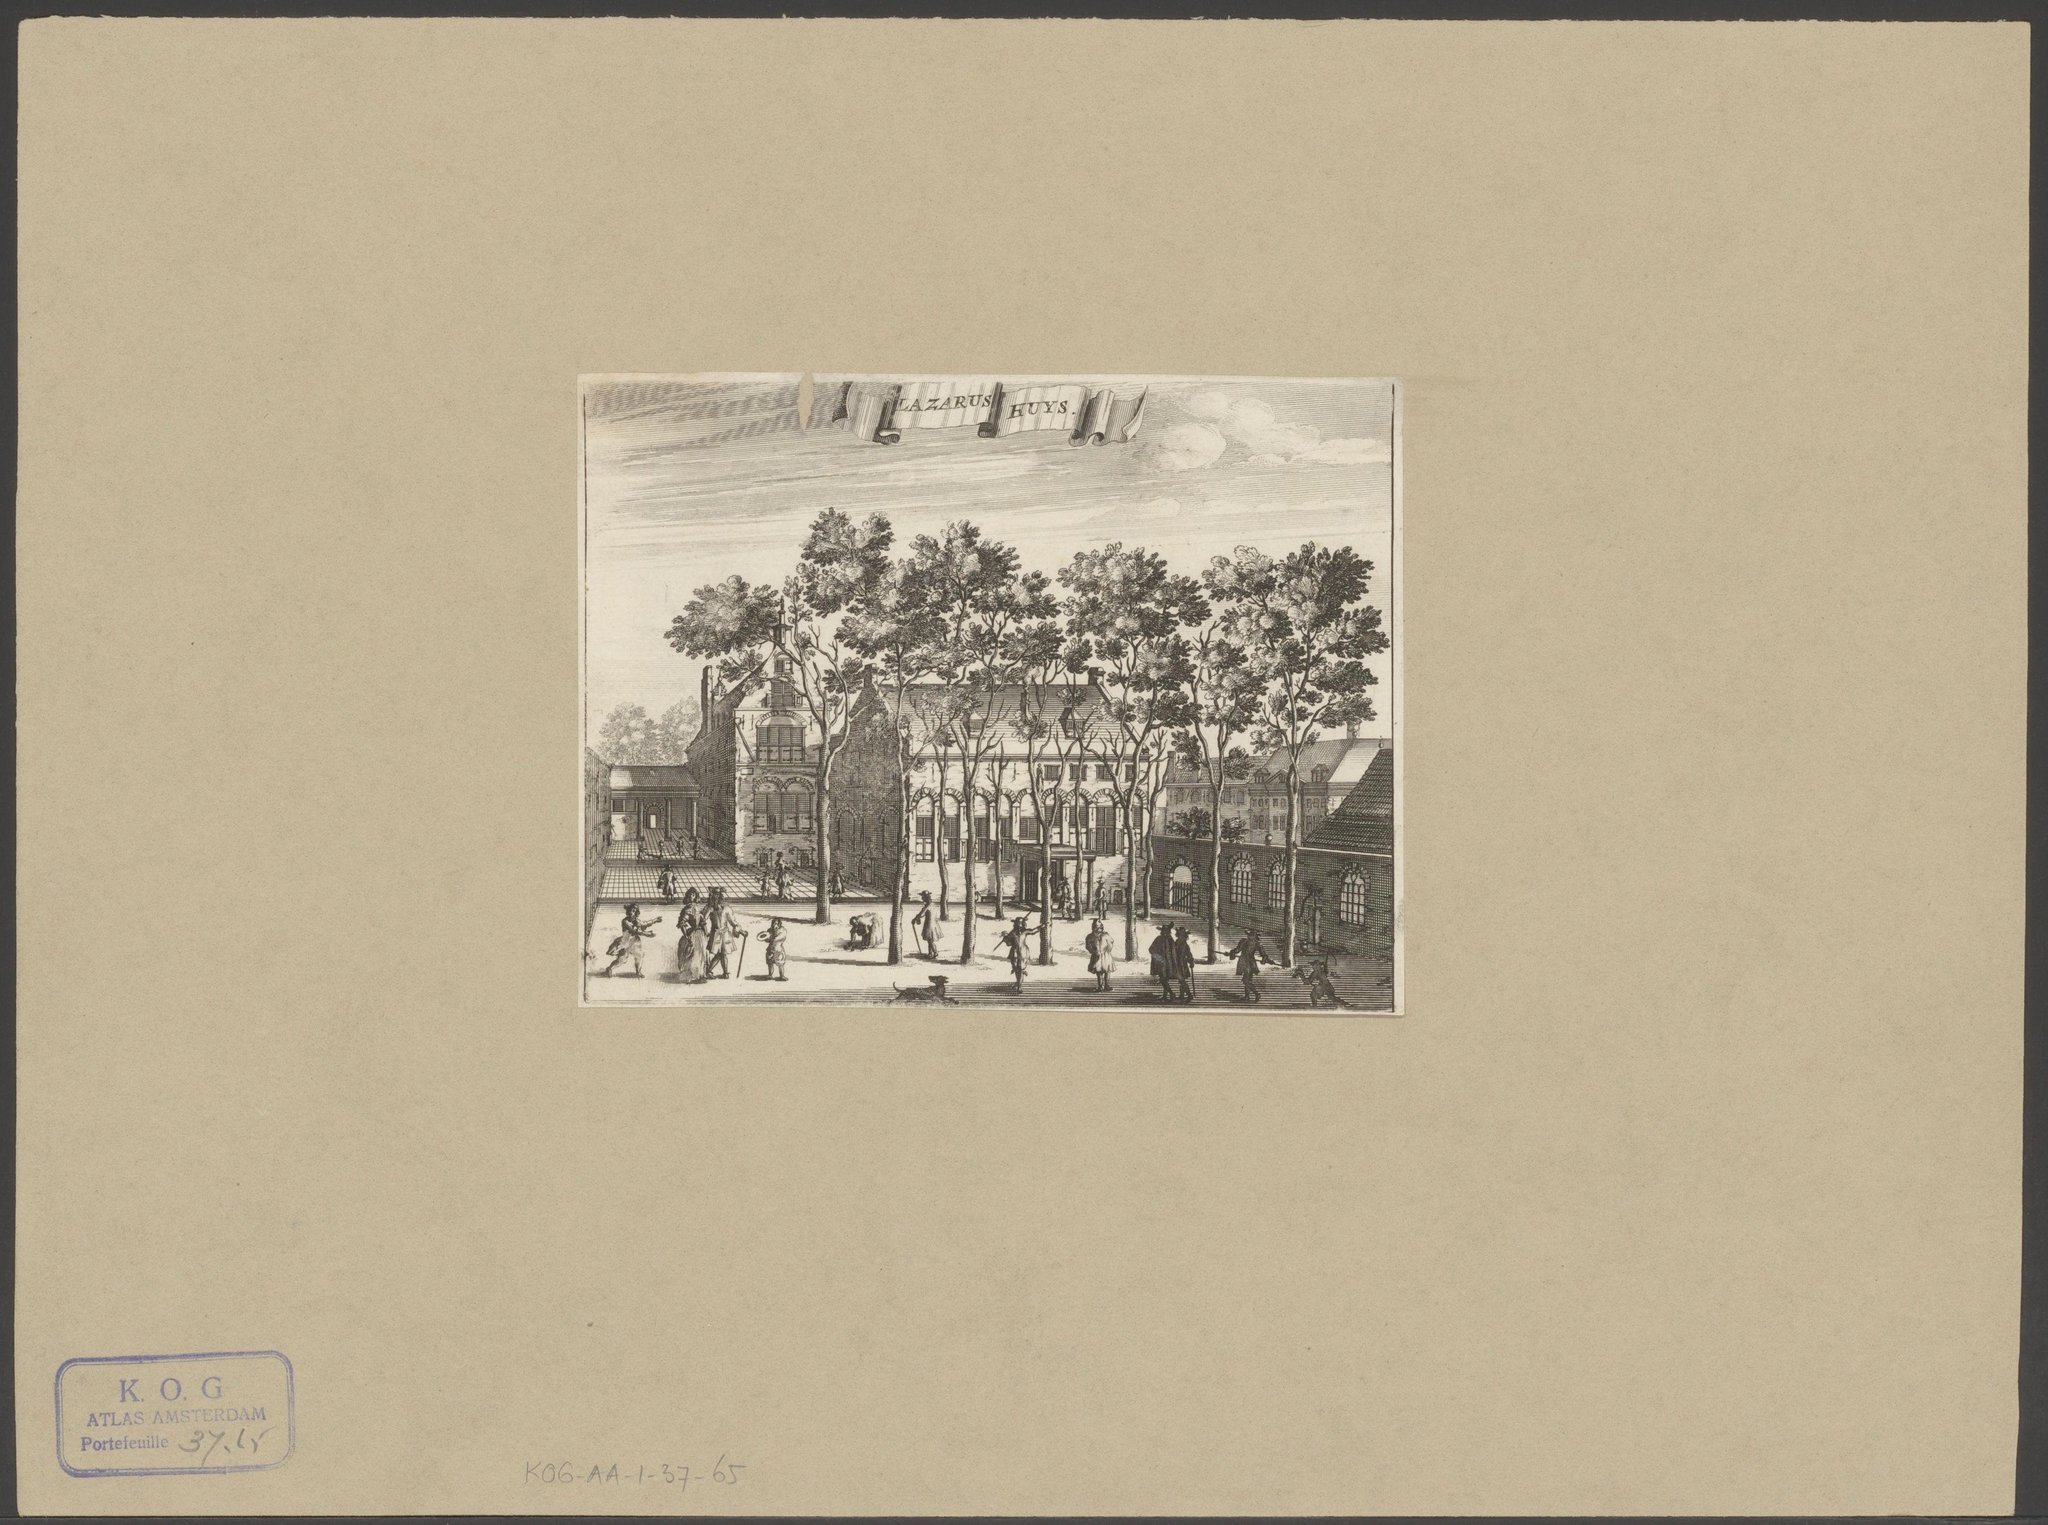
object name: print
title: Lazarus Huys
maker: Anonymous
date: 1693-1694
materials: paper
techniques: engraving, etching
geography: northern netherlands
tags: leprosarium, hospital, courtyard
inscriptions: collector's mark: Lugt 1641b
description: Huidige staat van prent ook gebruikt in: Commelin, Casparus. Beschryvinge van Amsterdam (…). Amsterdam: Abraham Wolfgang, Gillis Janssonius van Waesberge of Johannes Janssonius van Waesberge, Hendrick Boom of weduwe Dirk Boom, Abraham van Sanderen en Rembertus Goethals, 1693, dl. 1, p. 556. En in: Commelin, Casparus. Beschryvinge van Amsterdam (…). Amsterdam: weduwe Aart Dircksz. Oossaan, 1694, dl. 1, p. 556. Tweede staat van prent (met opgewerkte lucht) ook gebruikt in: Commelin, Casparus. Beschryvinge van Amsterdam (…). 2de druk. Amsterdam: Andries van Damme, Johannes Ratelband, weduwe Antony van Aeltwijk en Hermanus Uytwerf, 1726, dl. 1, p. 556.